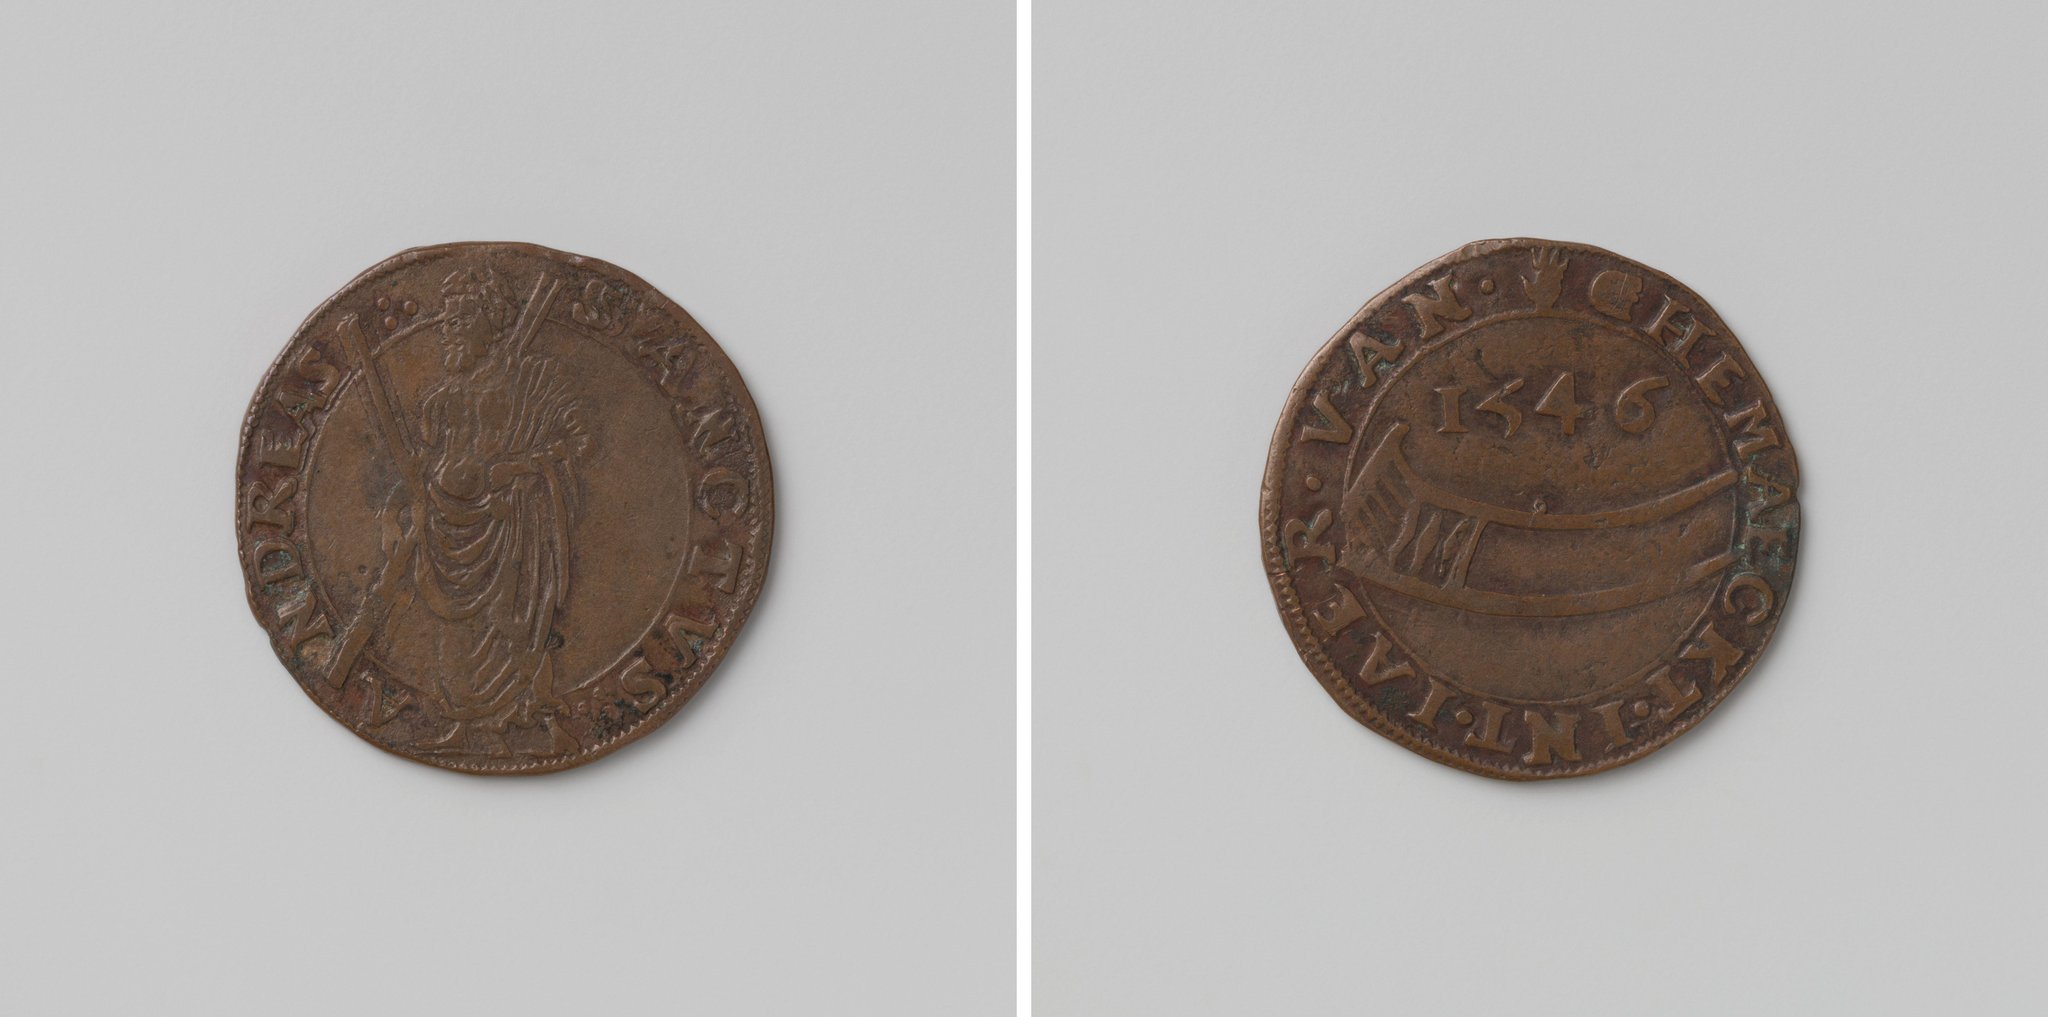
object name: medal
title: Sint Andreas- of kruiersgilde van Antwerpen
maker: Anonymous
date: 1546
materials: copper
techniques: striking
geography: antwerp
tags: antwerp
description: Koperen penning. Voorzijde: Andreas met kruis binnen omschrift. Keerzijde: sleep onder jaartal binnen omschrift